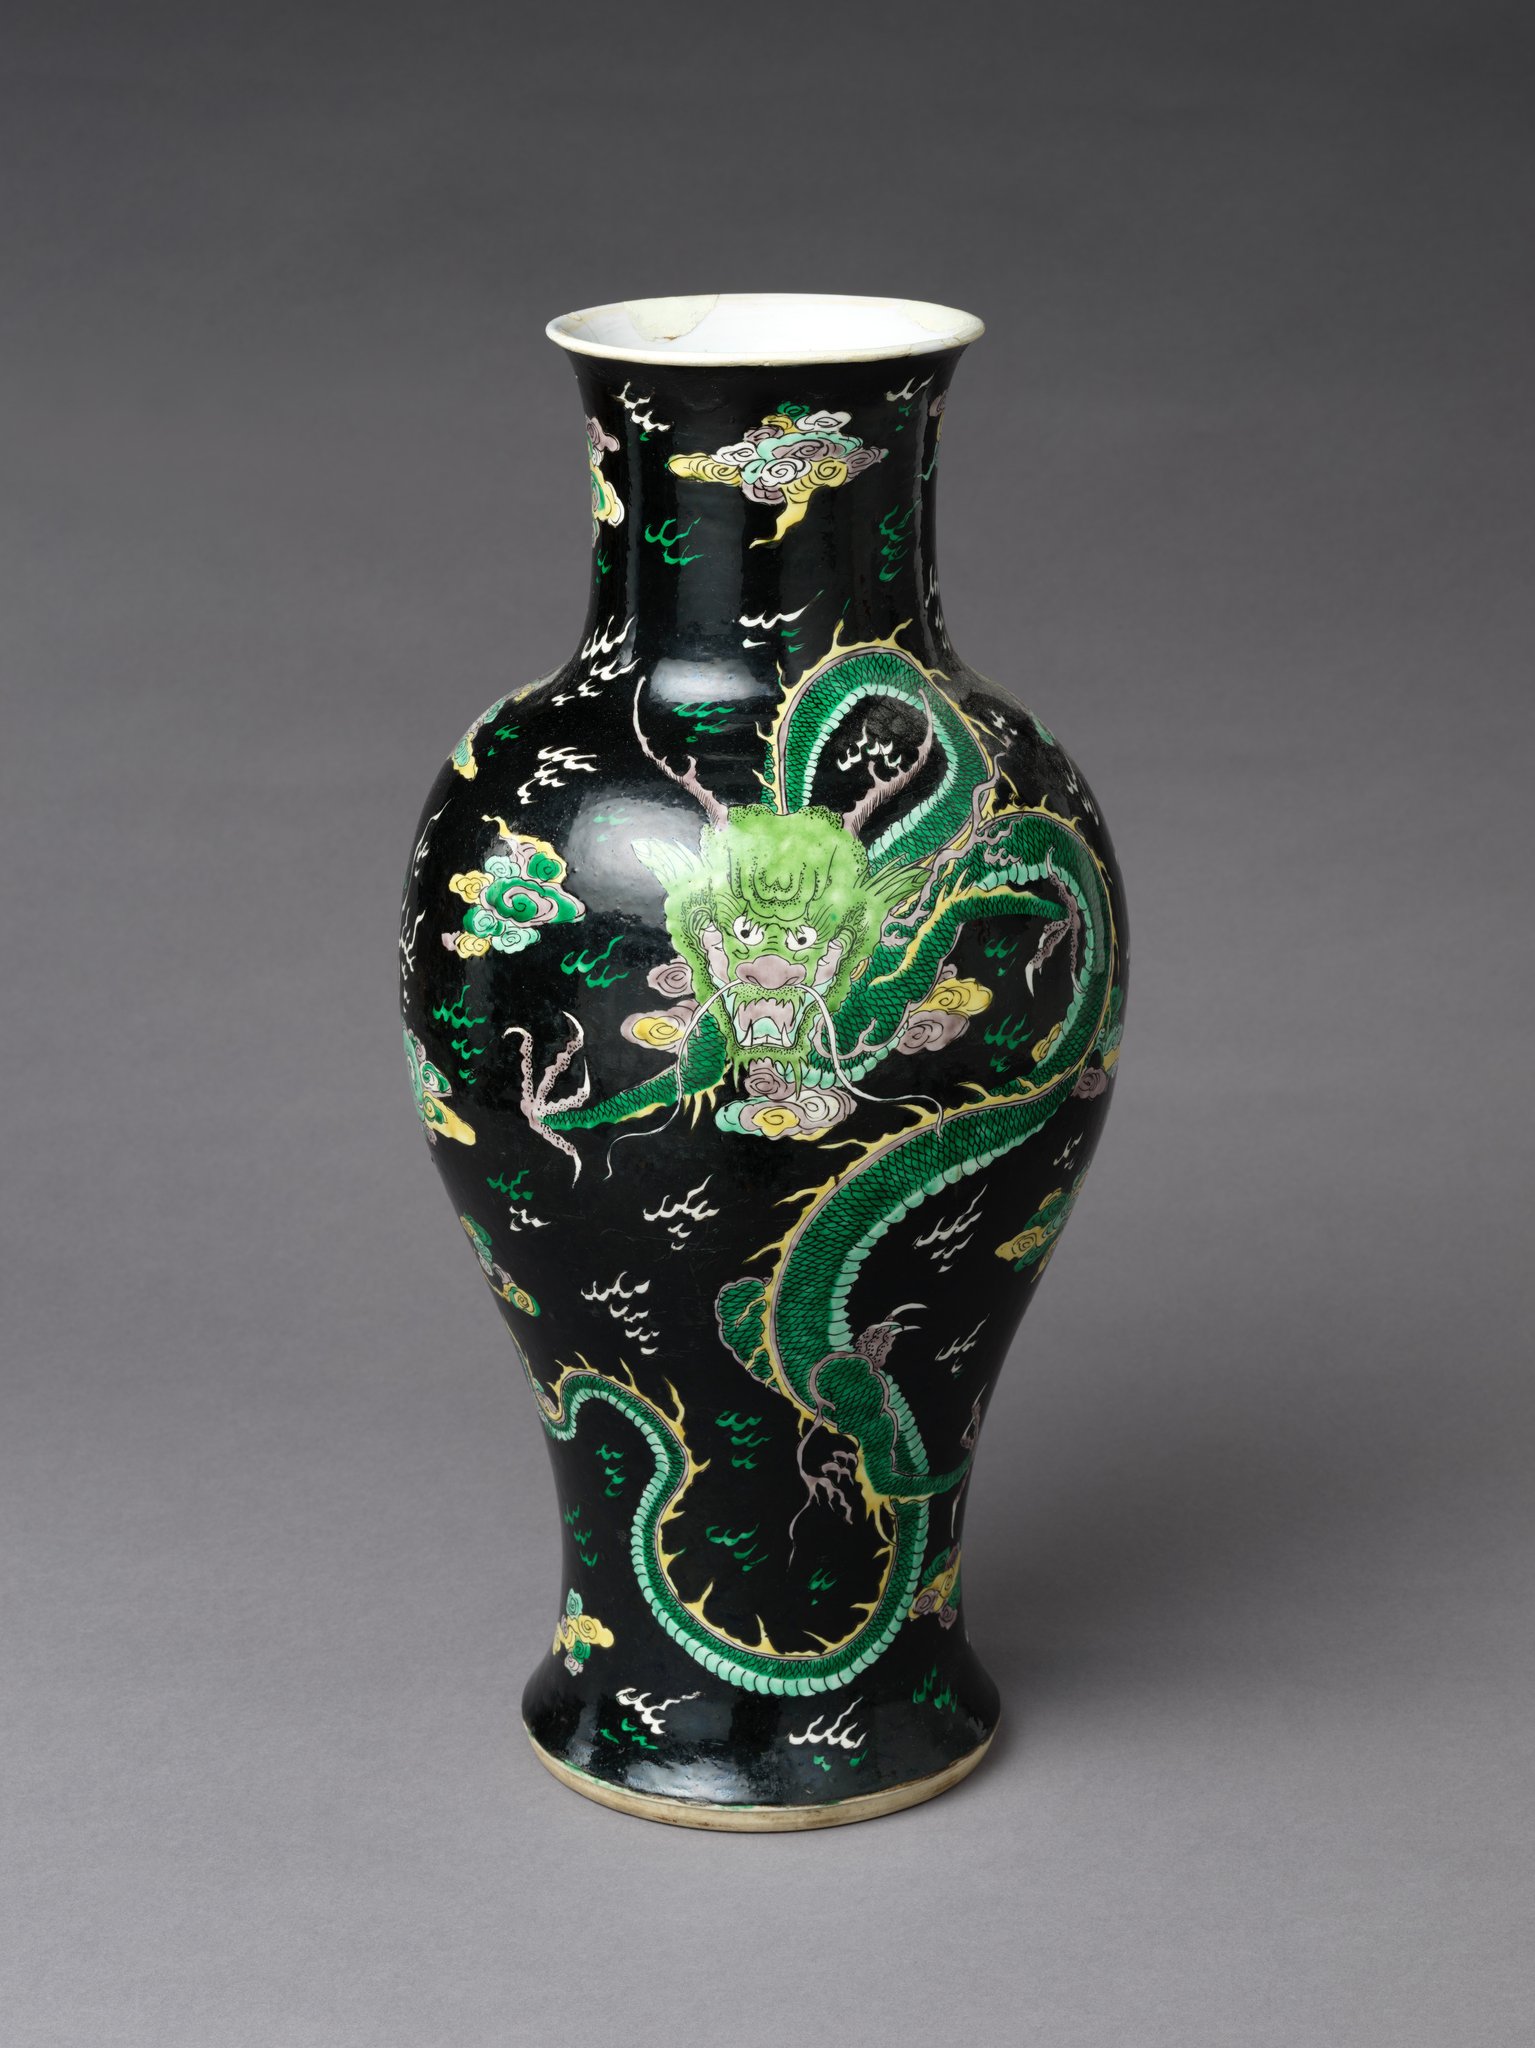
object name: vase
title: Vase with dragon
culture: chinese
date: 1701-1900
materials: enamel, porcelain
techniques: painting, polychrome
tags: dragons